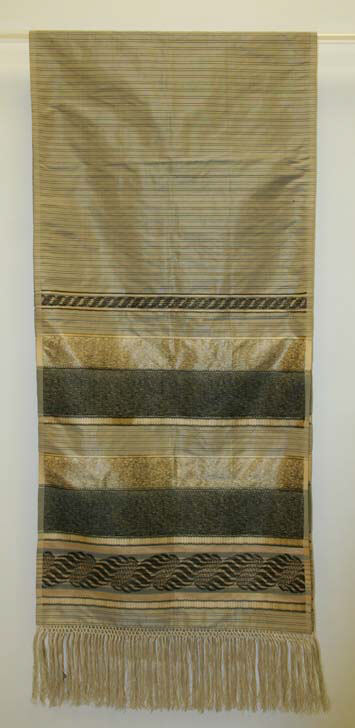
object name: scarf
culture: american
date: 1850-1859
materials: silk